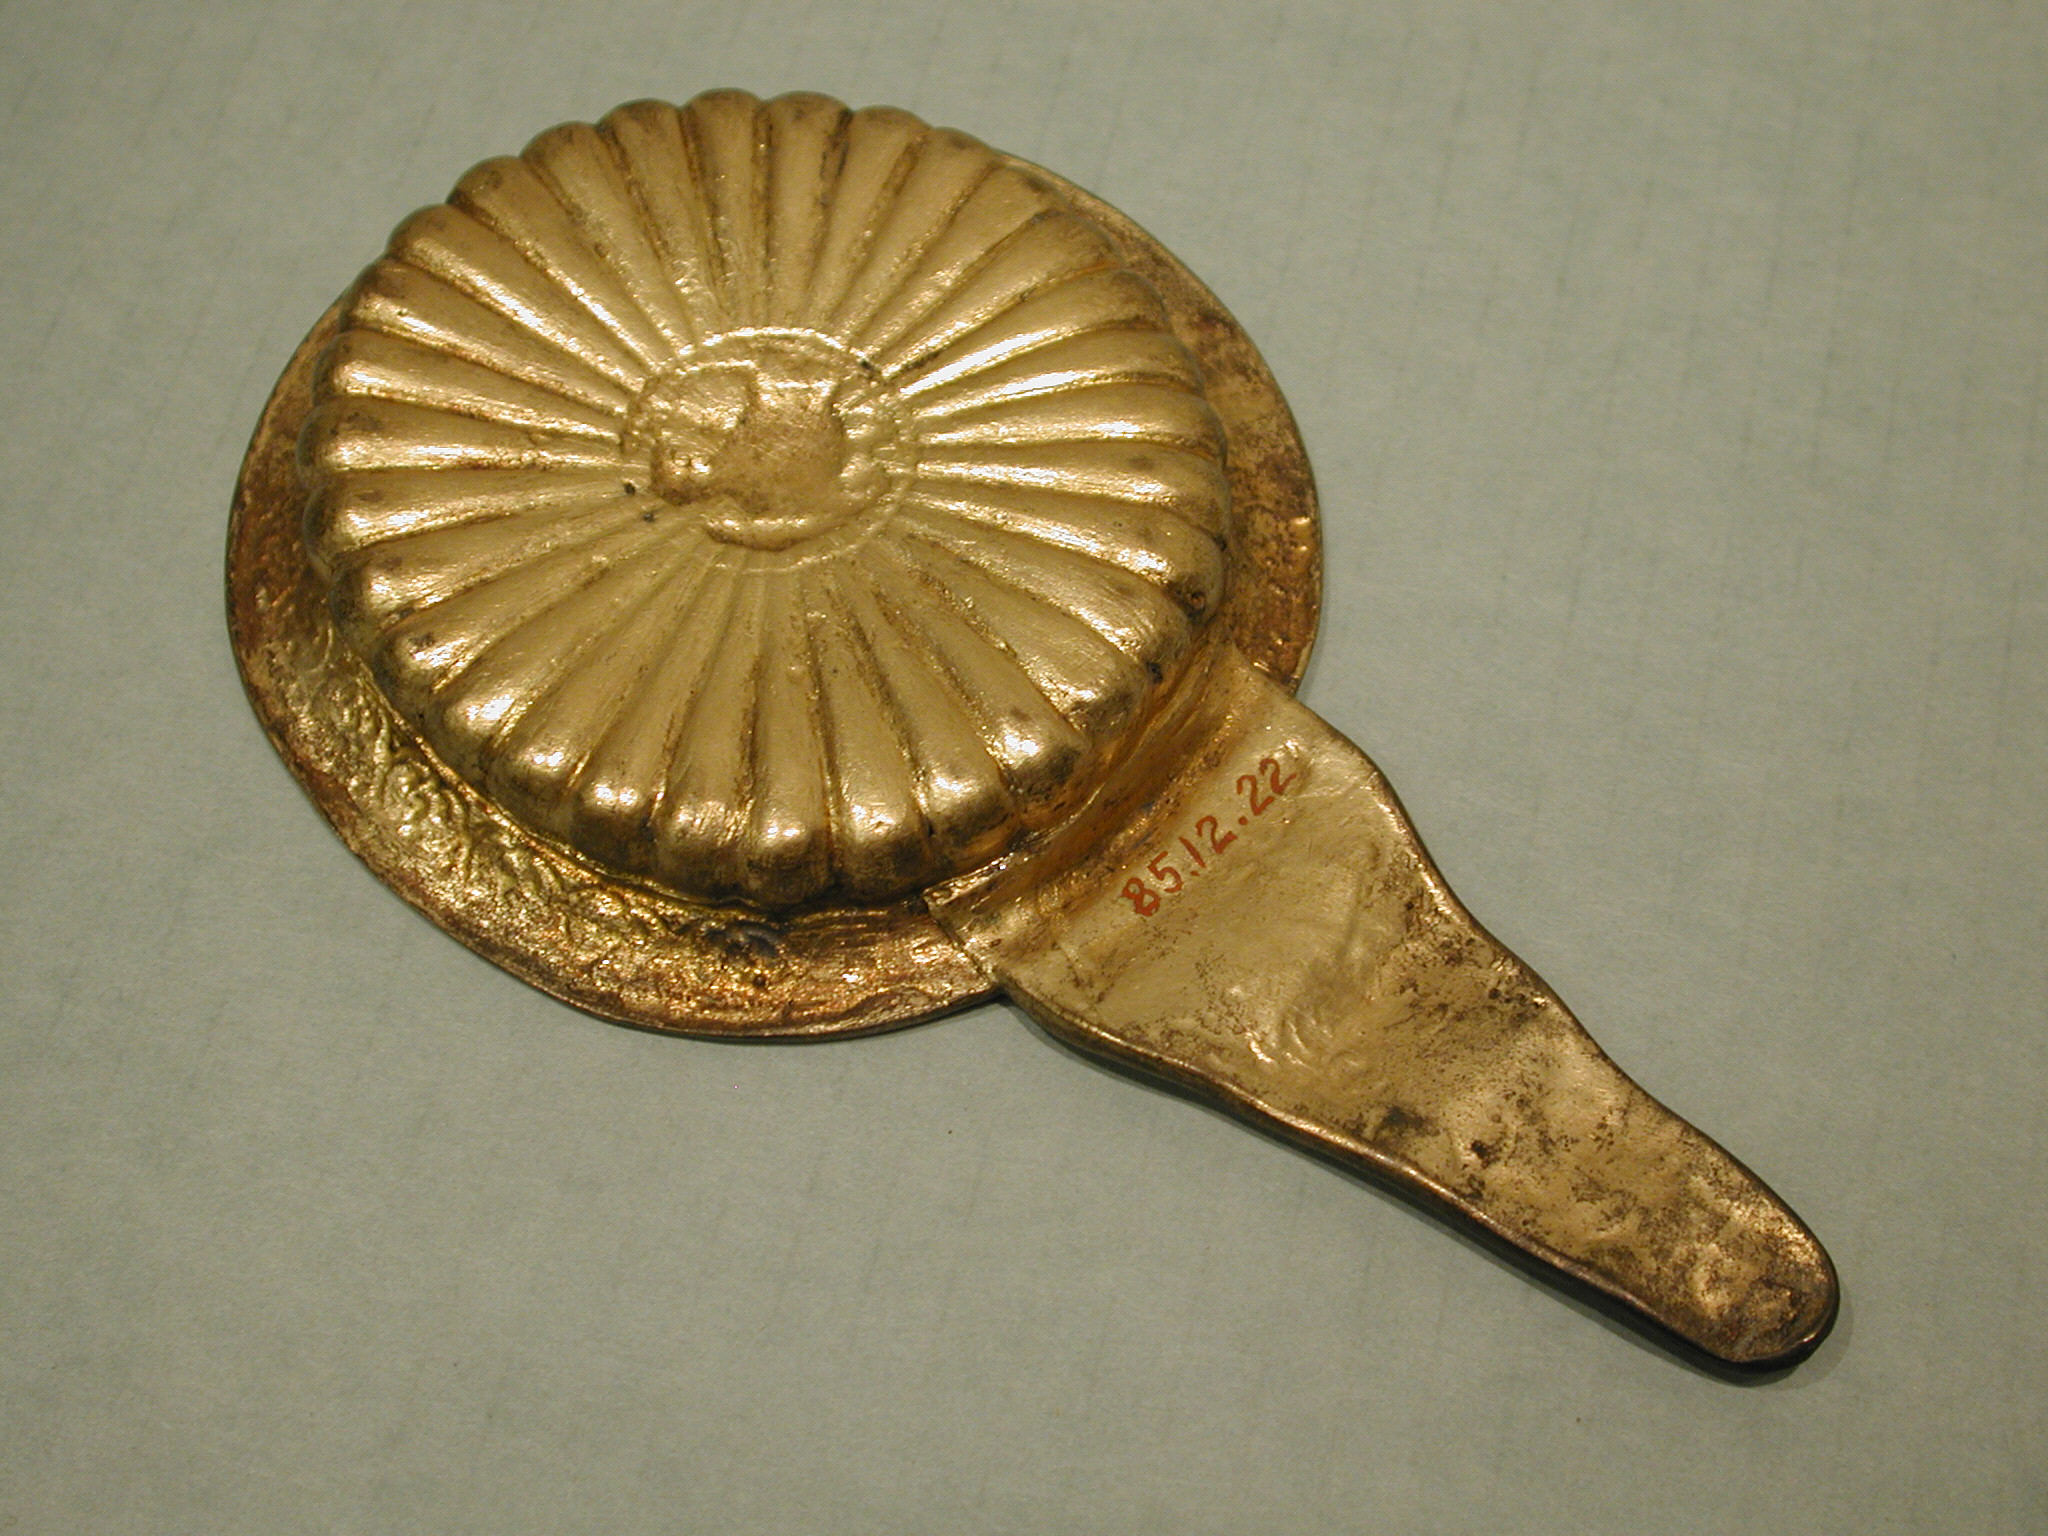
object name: bowl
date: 1801-1900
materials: metal